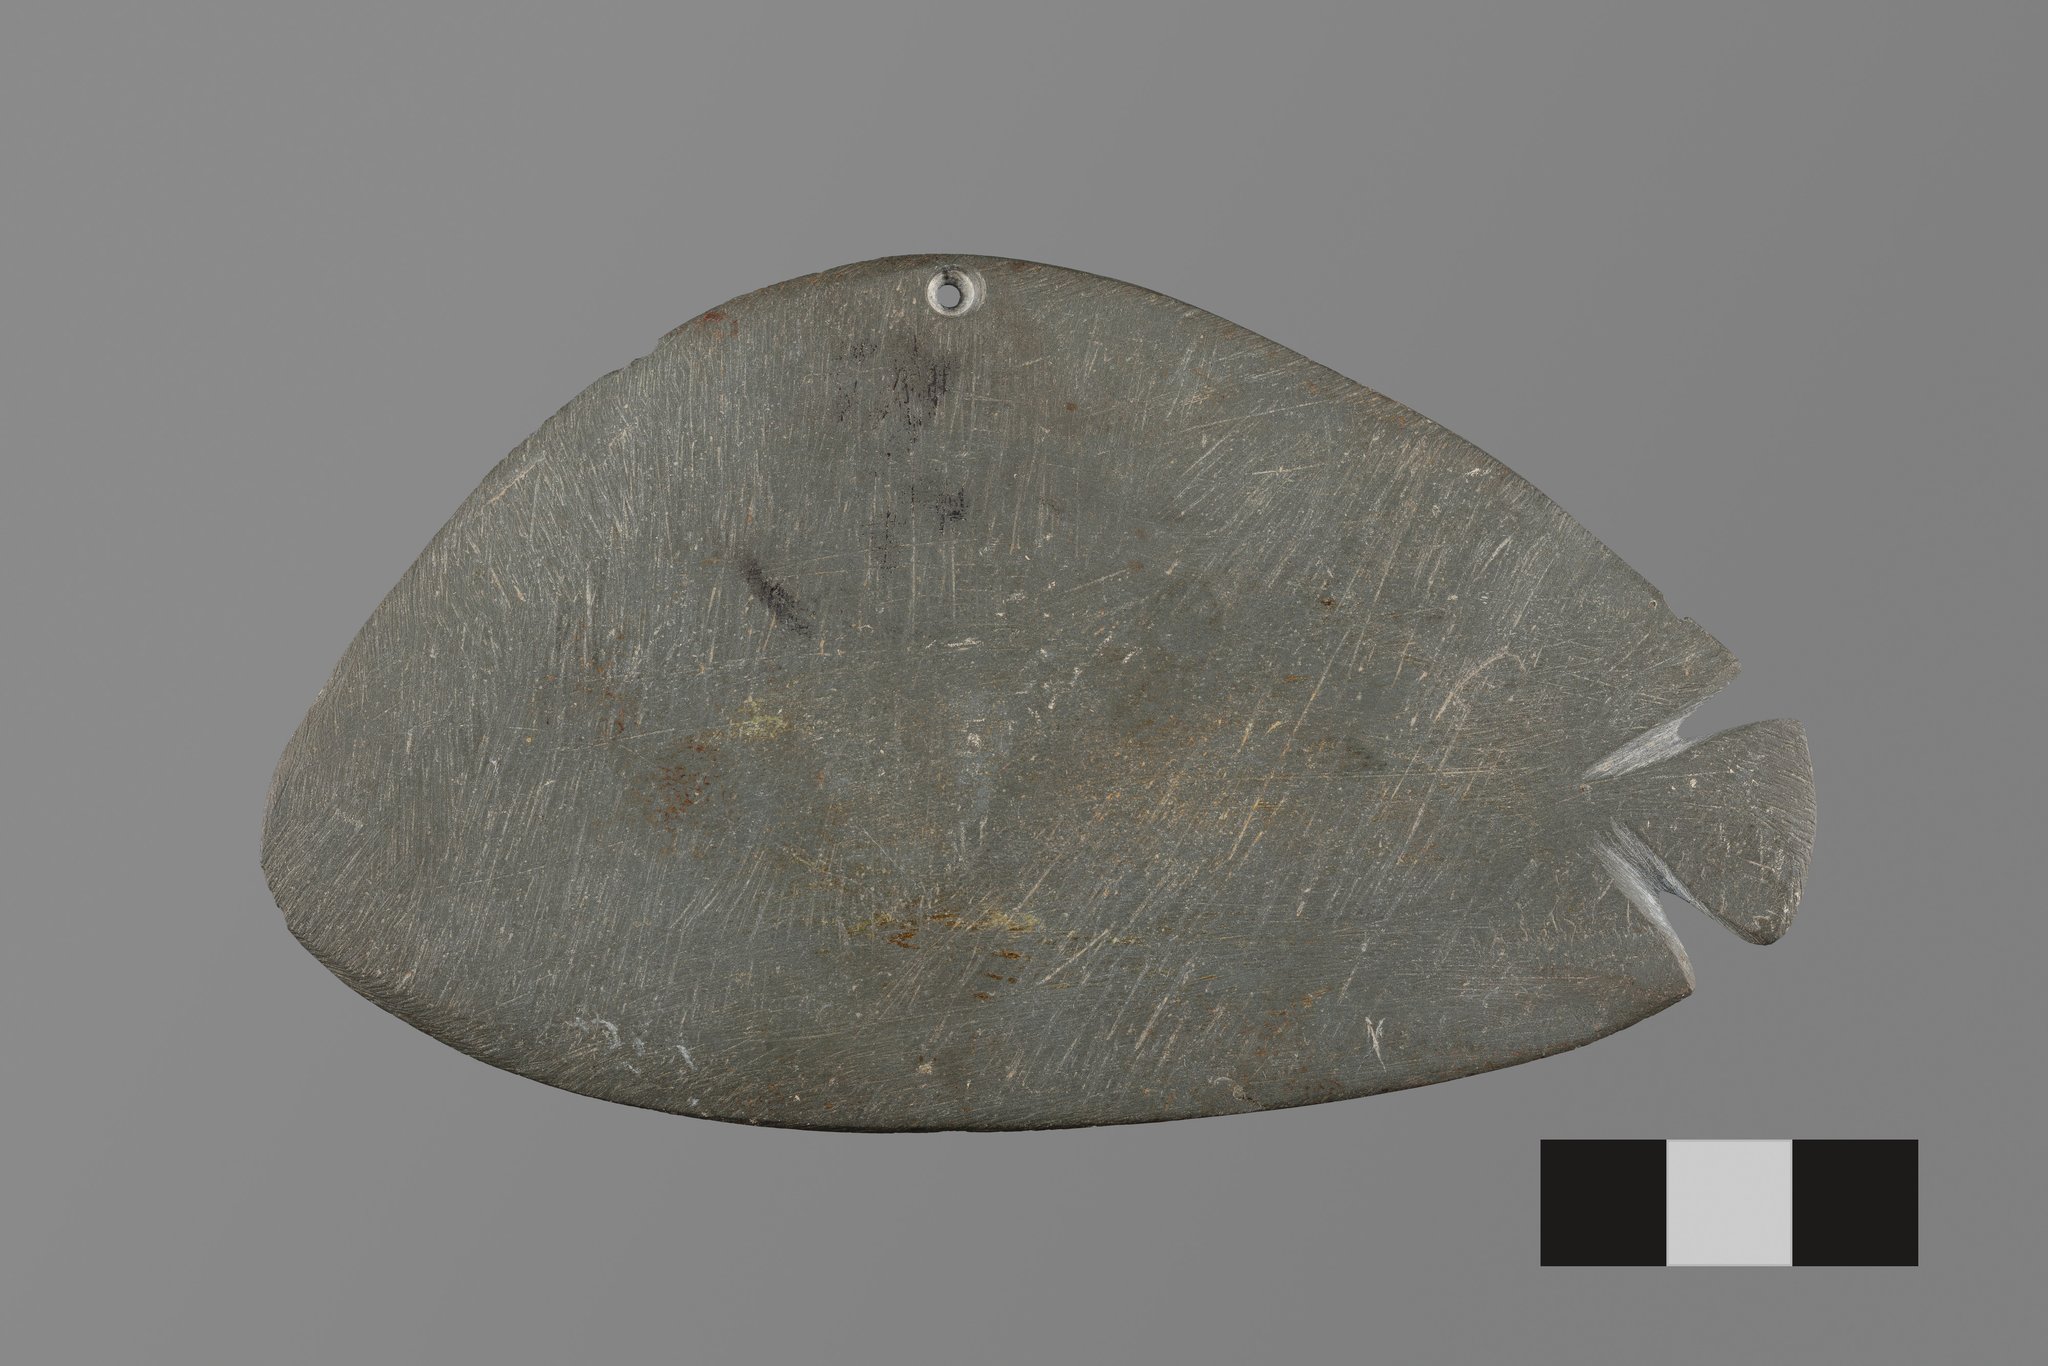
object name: palette, fish shaped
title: Palette in the shape of a fish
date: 3650-3300 BCE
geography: egypt